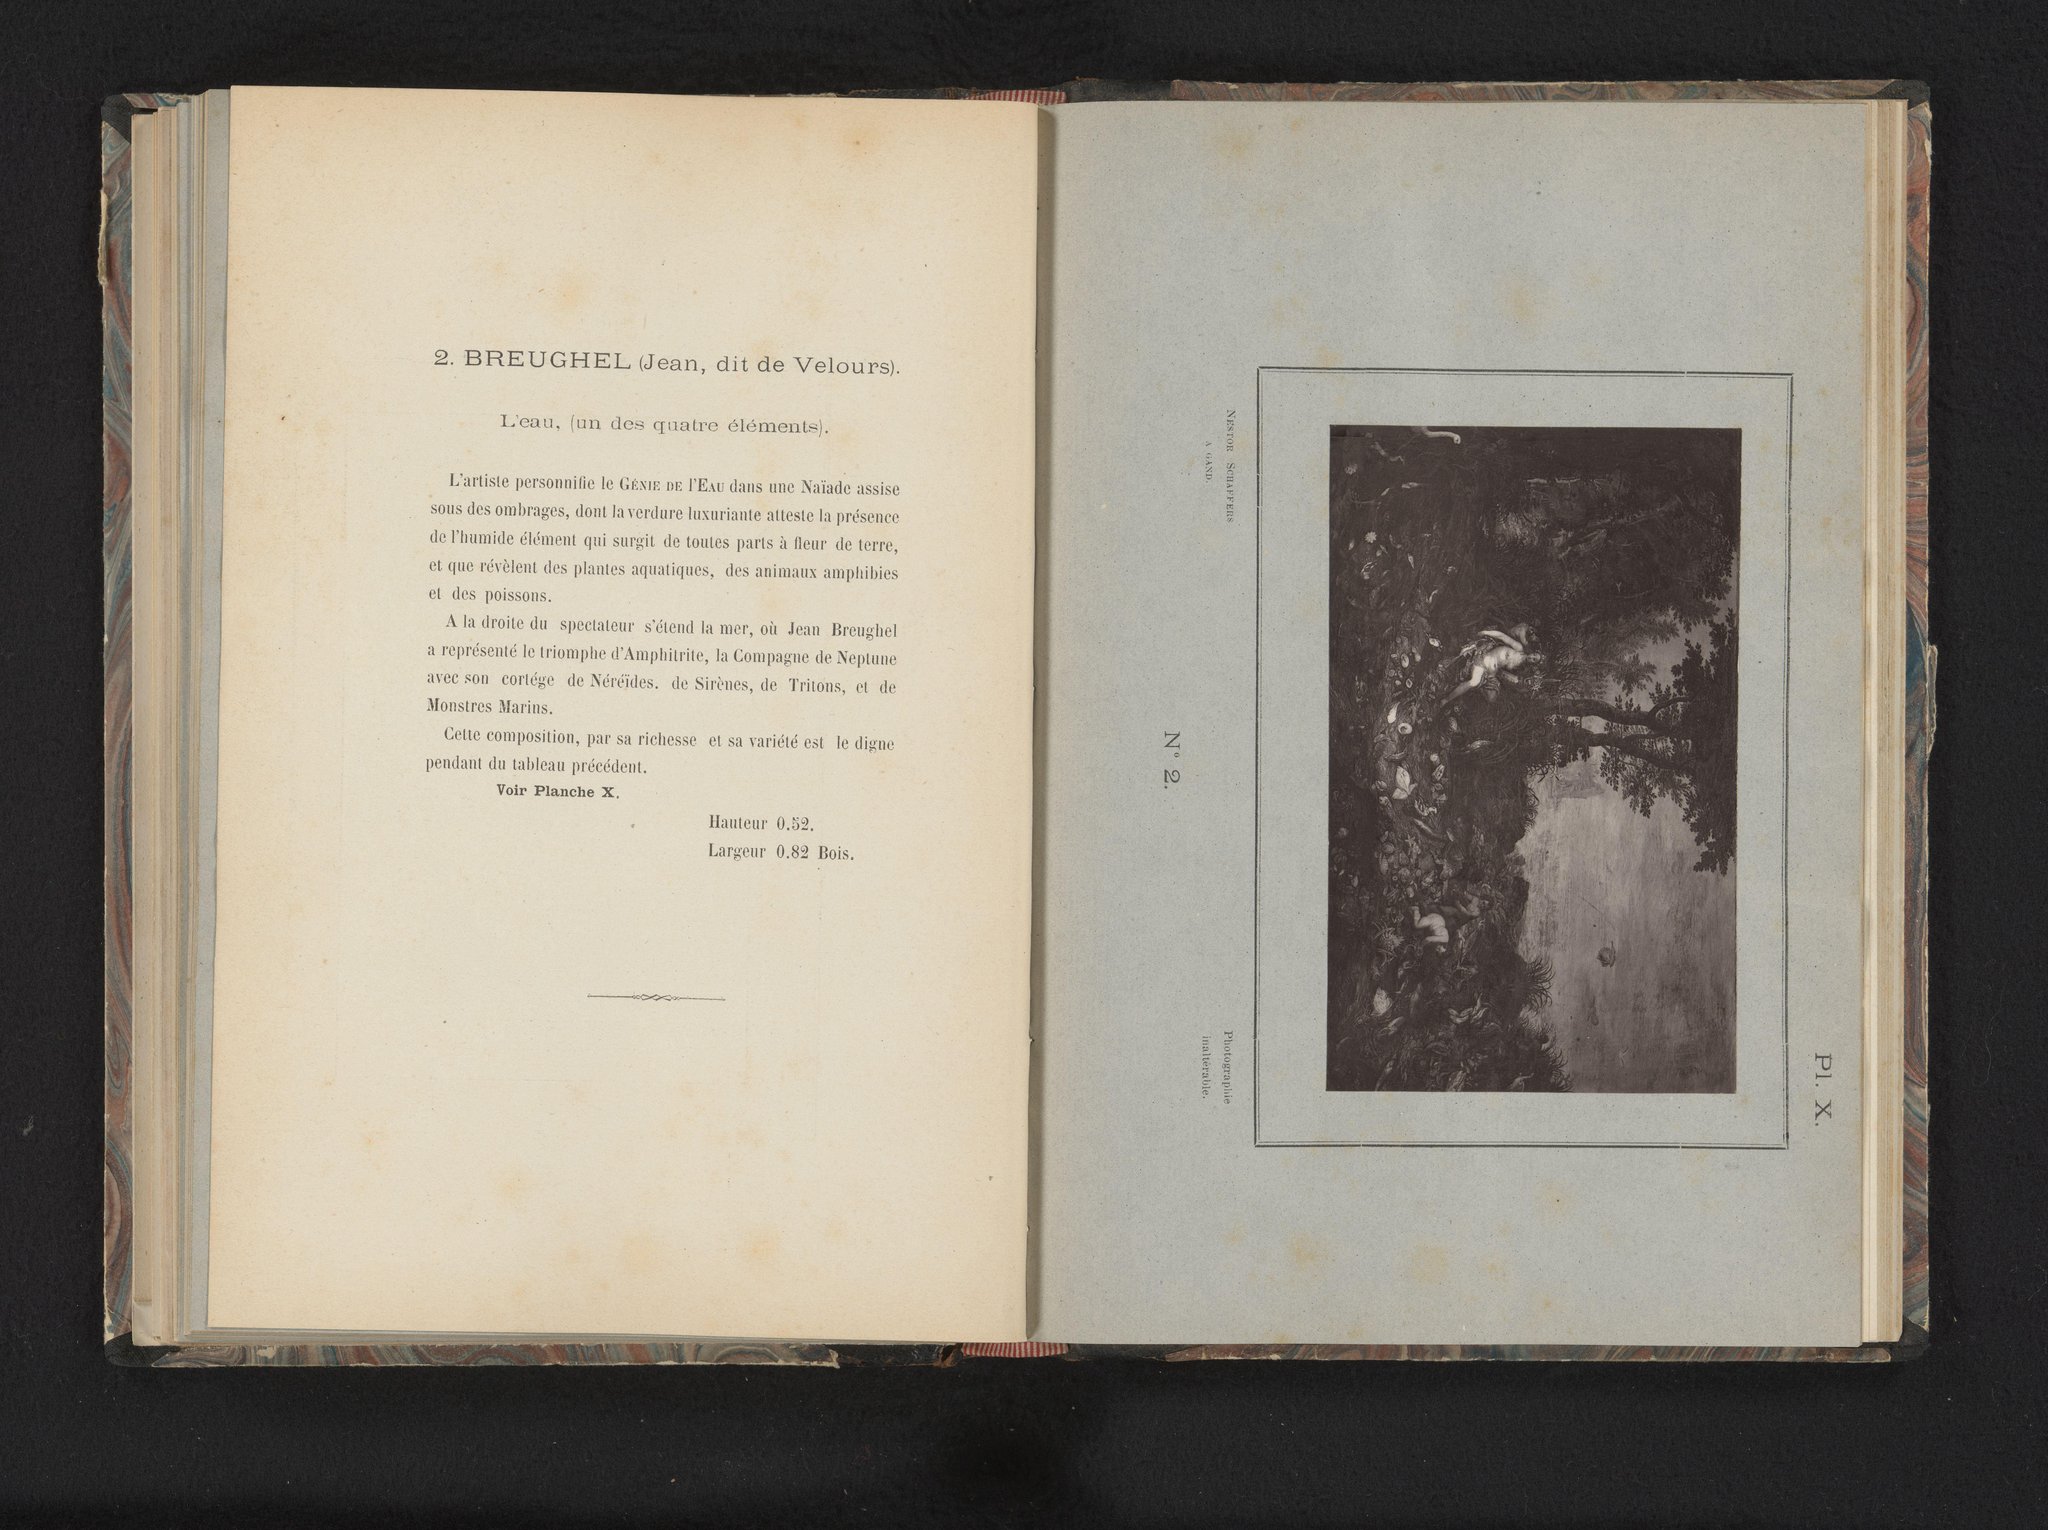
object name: page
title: Fotoreproductie van de allegorie van het water door Jan Brueghel I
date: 1899-1904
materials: paper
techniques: carbon print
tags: water (one of the four elements)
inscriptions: inscription: ‘PL. X./ No 2.’